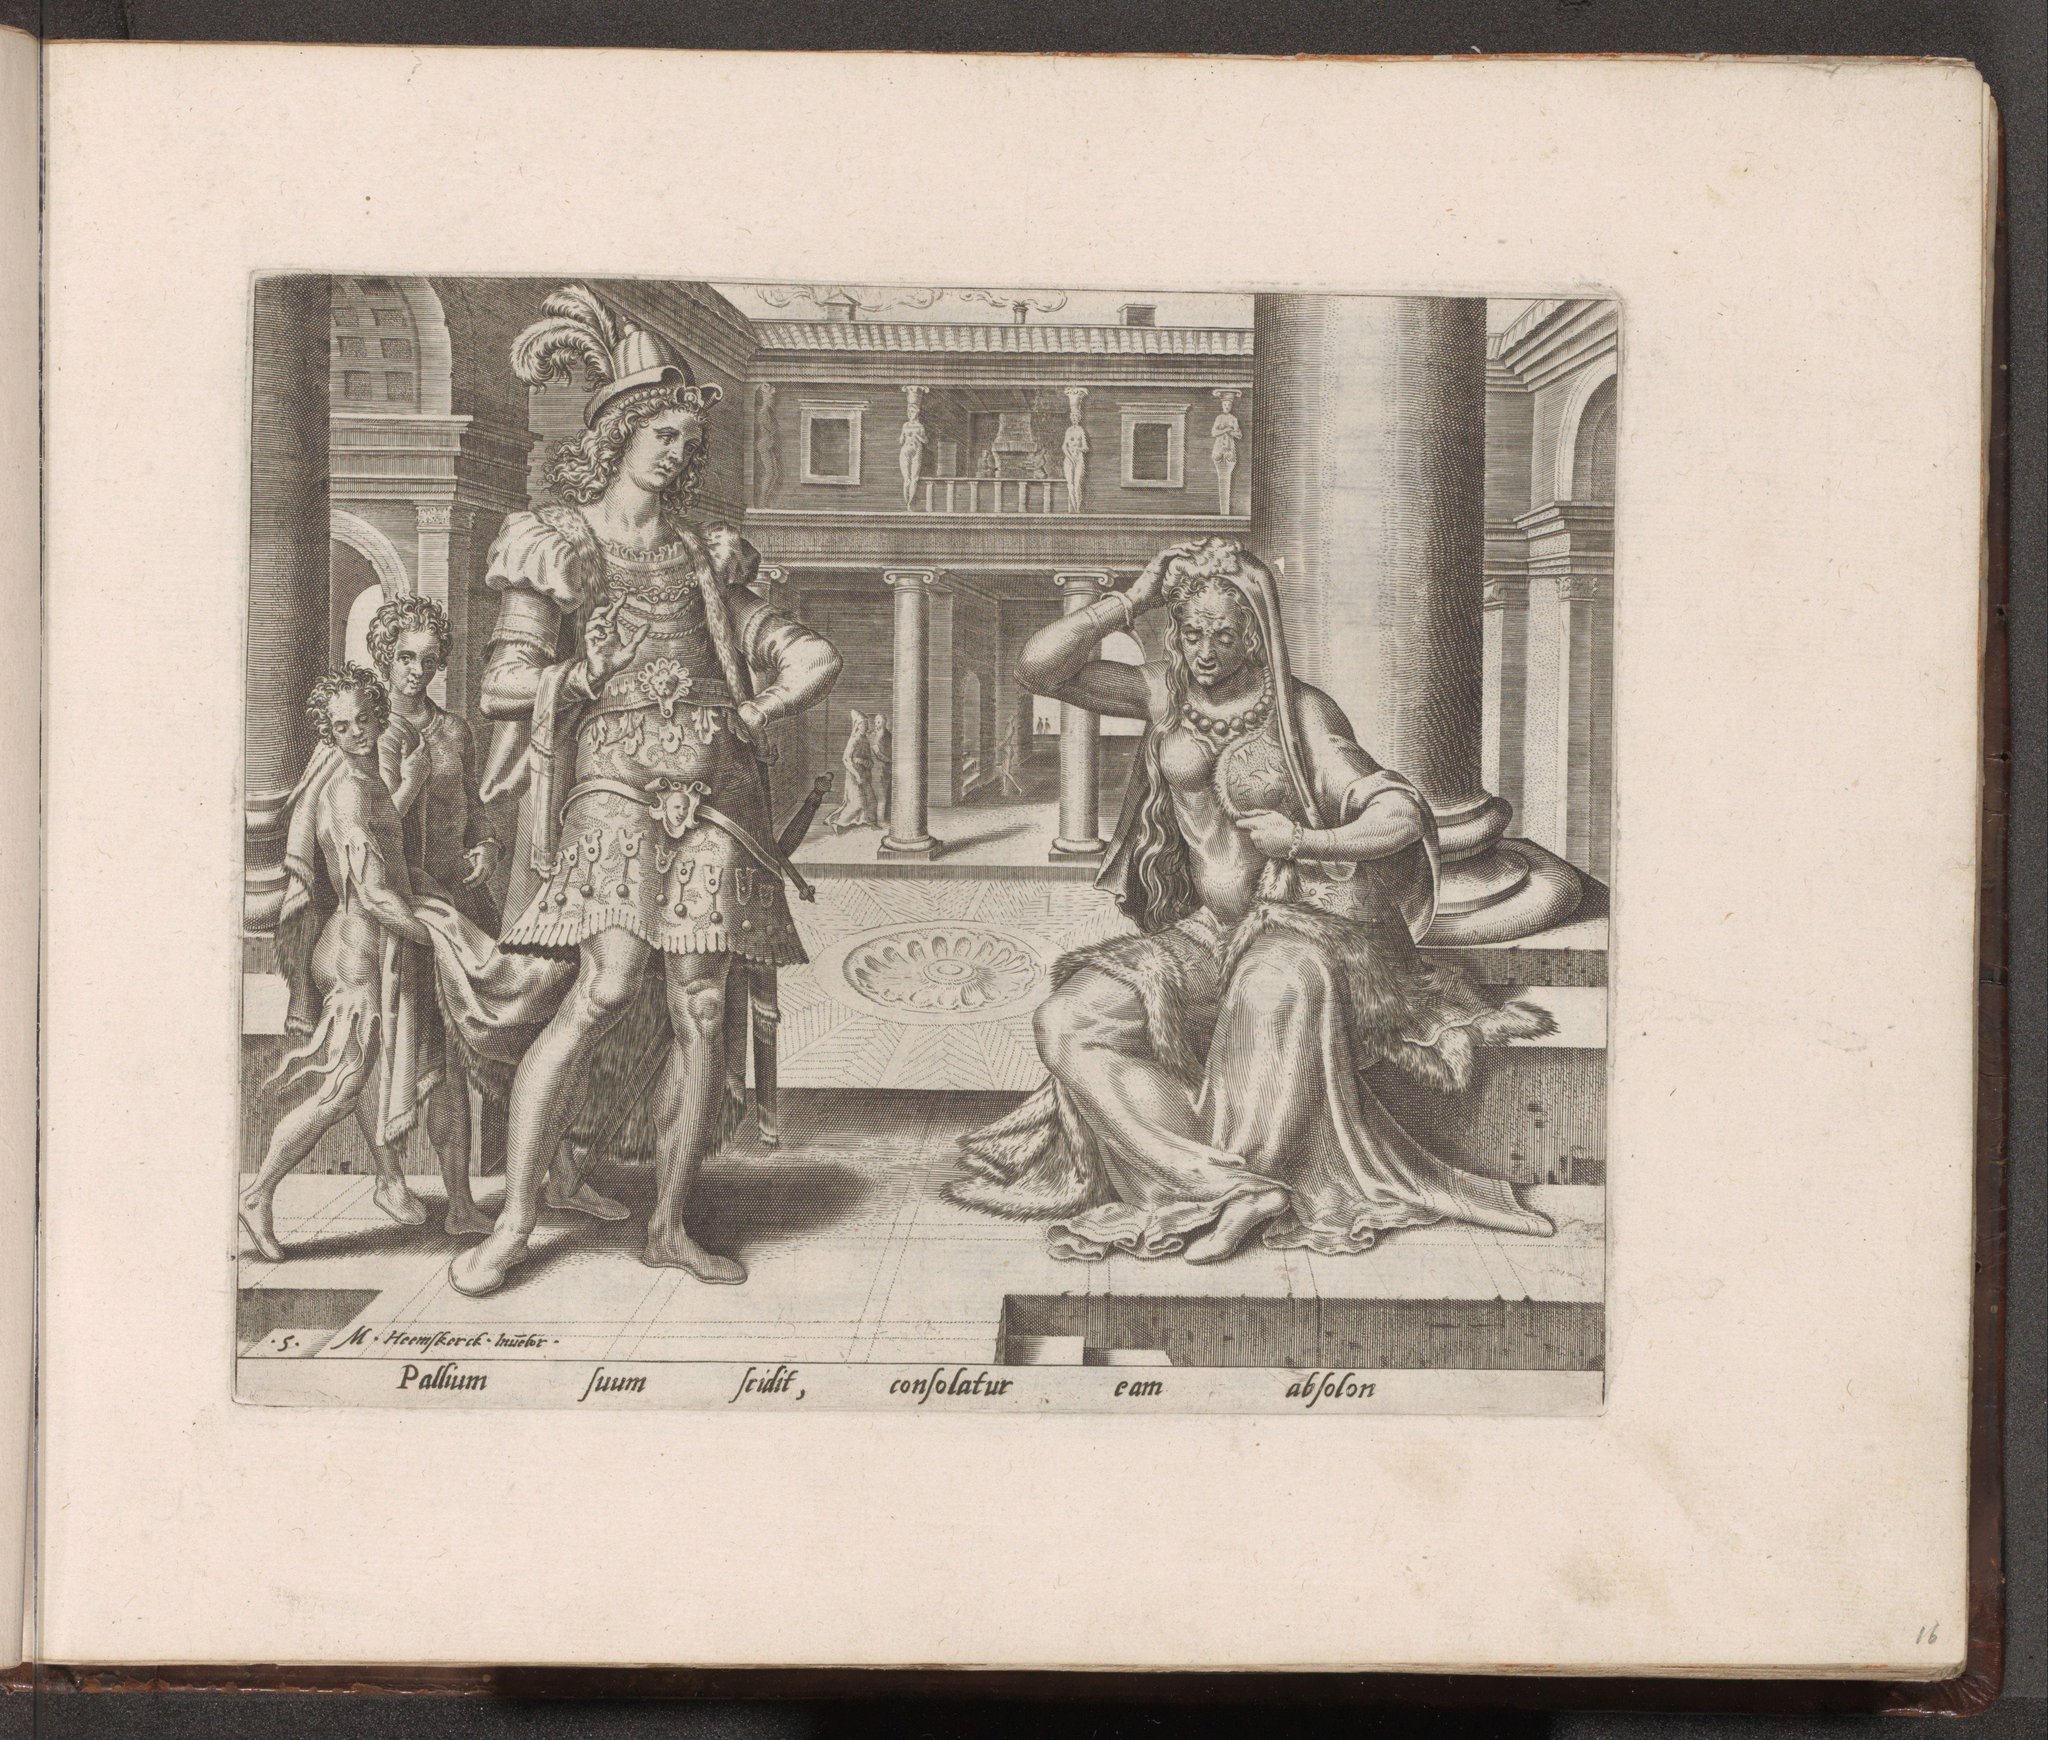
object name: print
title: Historia Bersabee (...)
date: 1559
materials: paper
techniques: engraving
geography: antwerp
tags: absalom consoles tamar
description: Tamar zit op straat onder een pilaar en zij strooit stof op haar hoofd en scheurt haar veelkleurige kleed, omdat ze is verkracht door Amnon. Haar broer Absalom zoekt haar op, gevolgd door twee bedienden, en draagt haar op over het voorval te zwijgen. Onder de voorstelling een verwijzing in het Latijn naar de Bijbeltekst. Prent maakt deel uit van een album.